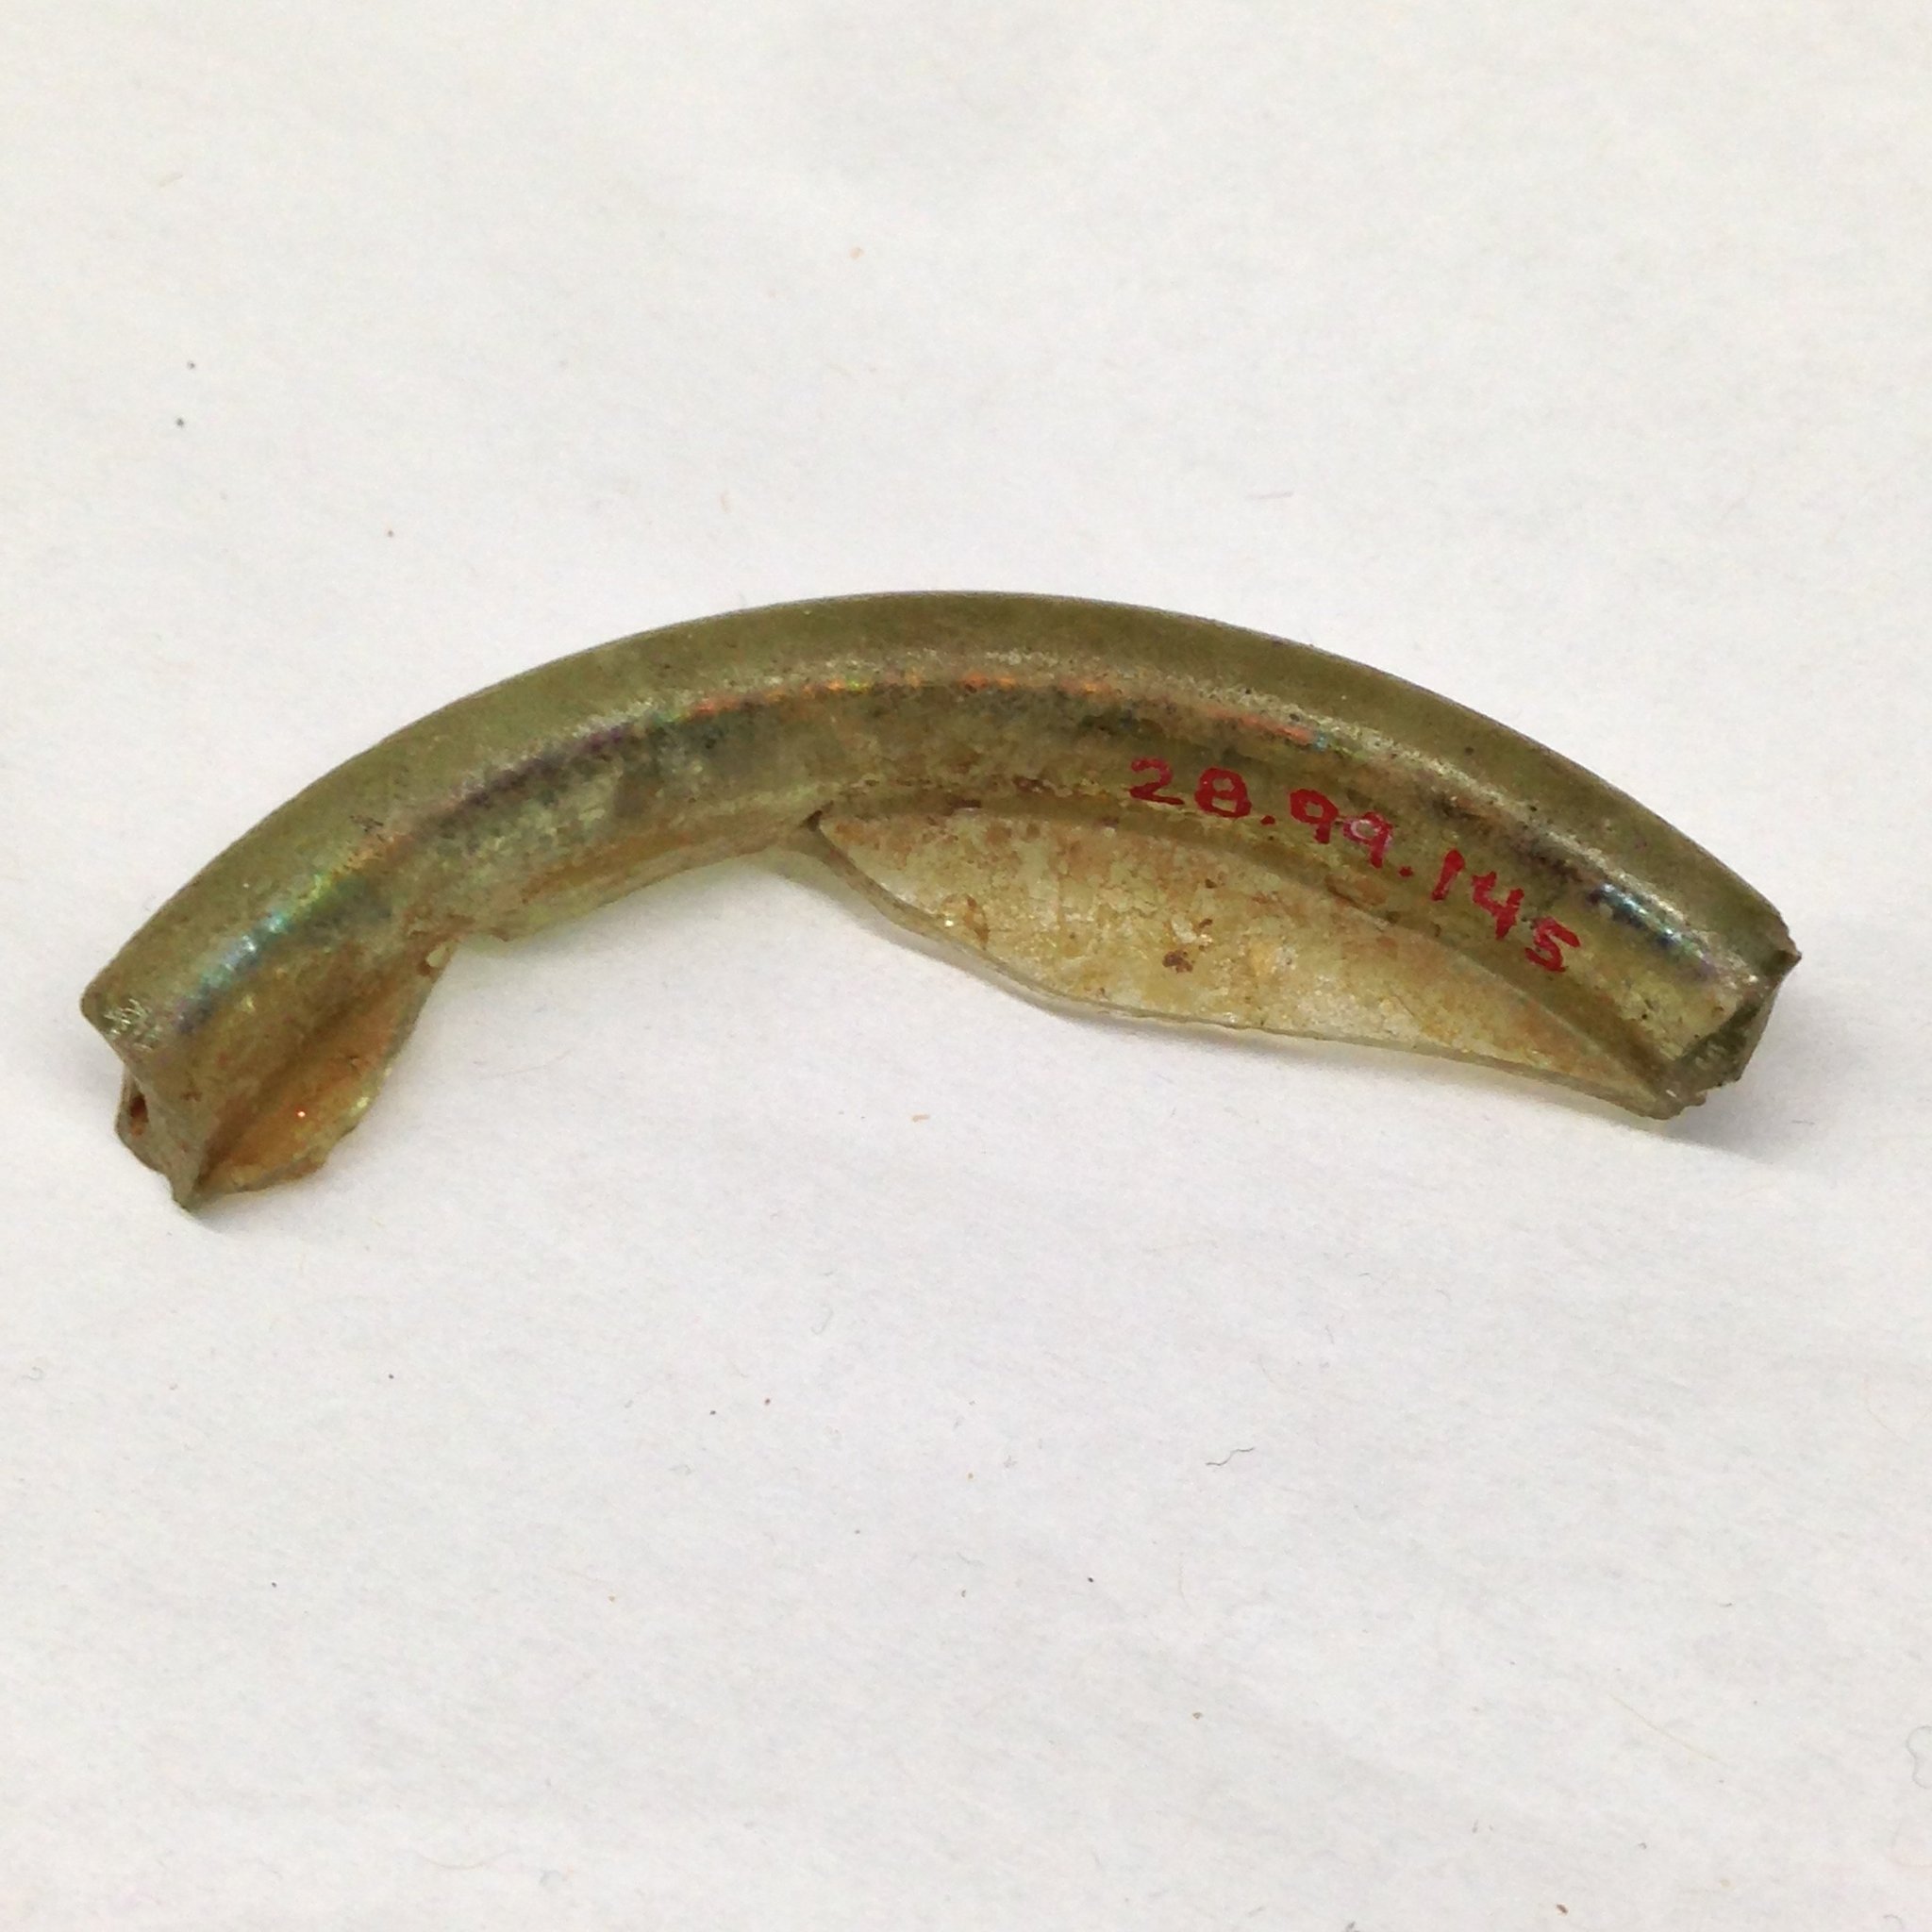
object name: fragment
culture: european or middle eastern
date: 1150-1250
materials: ceramic, glass